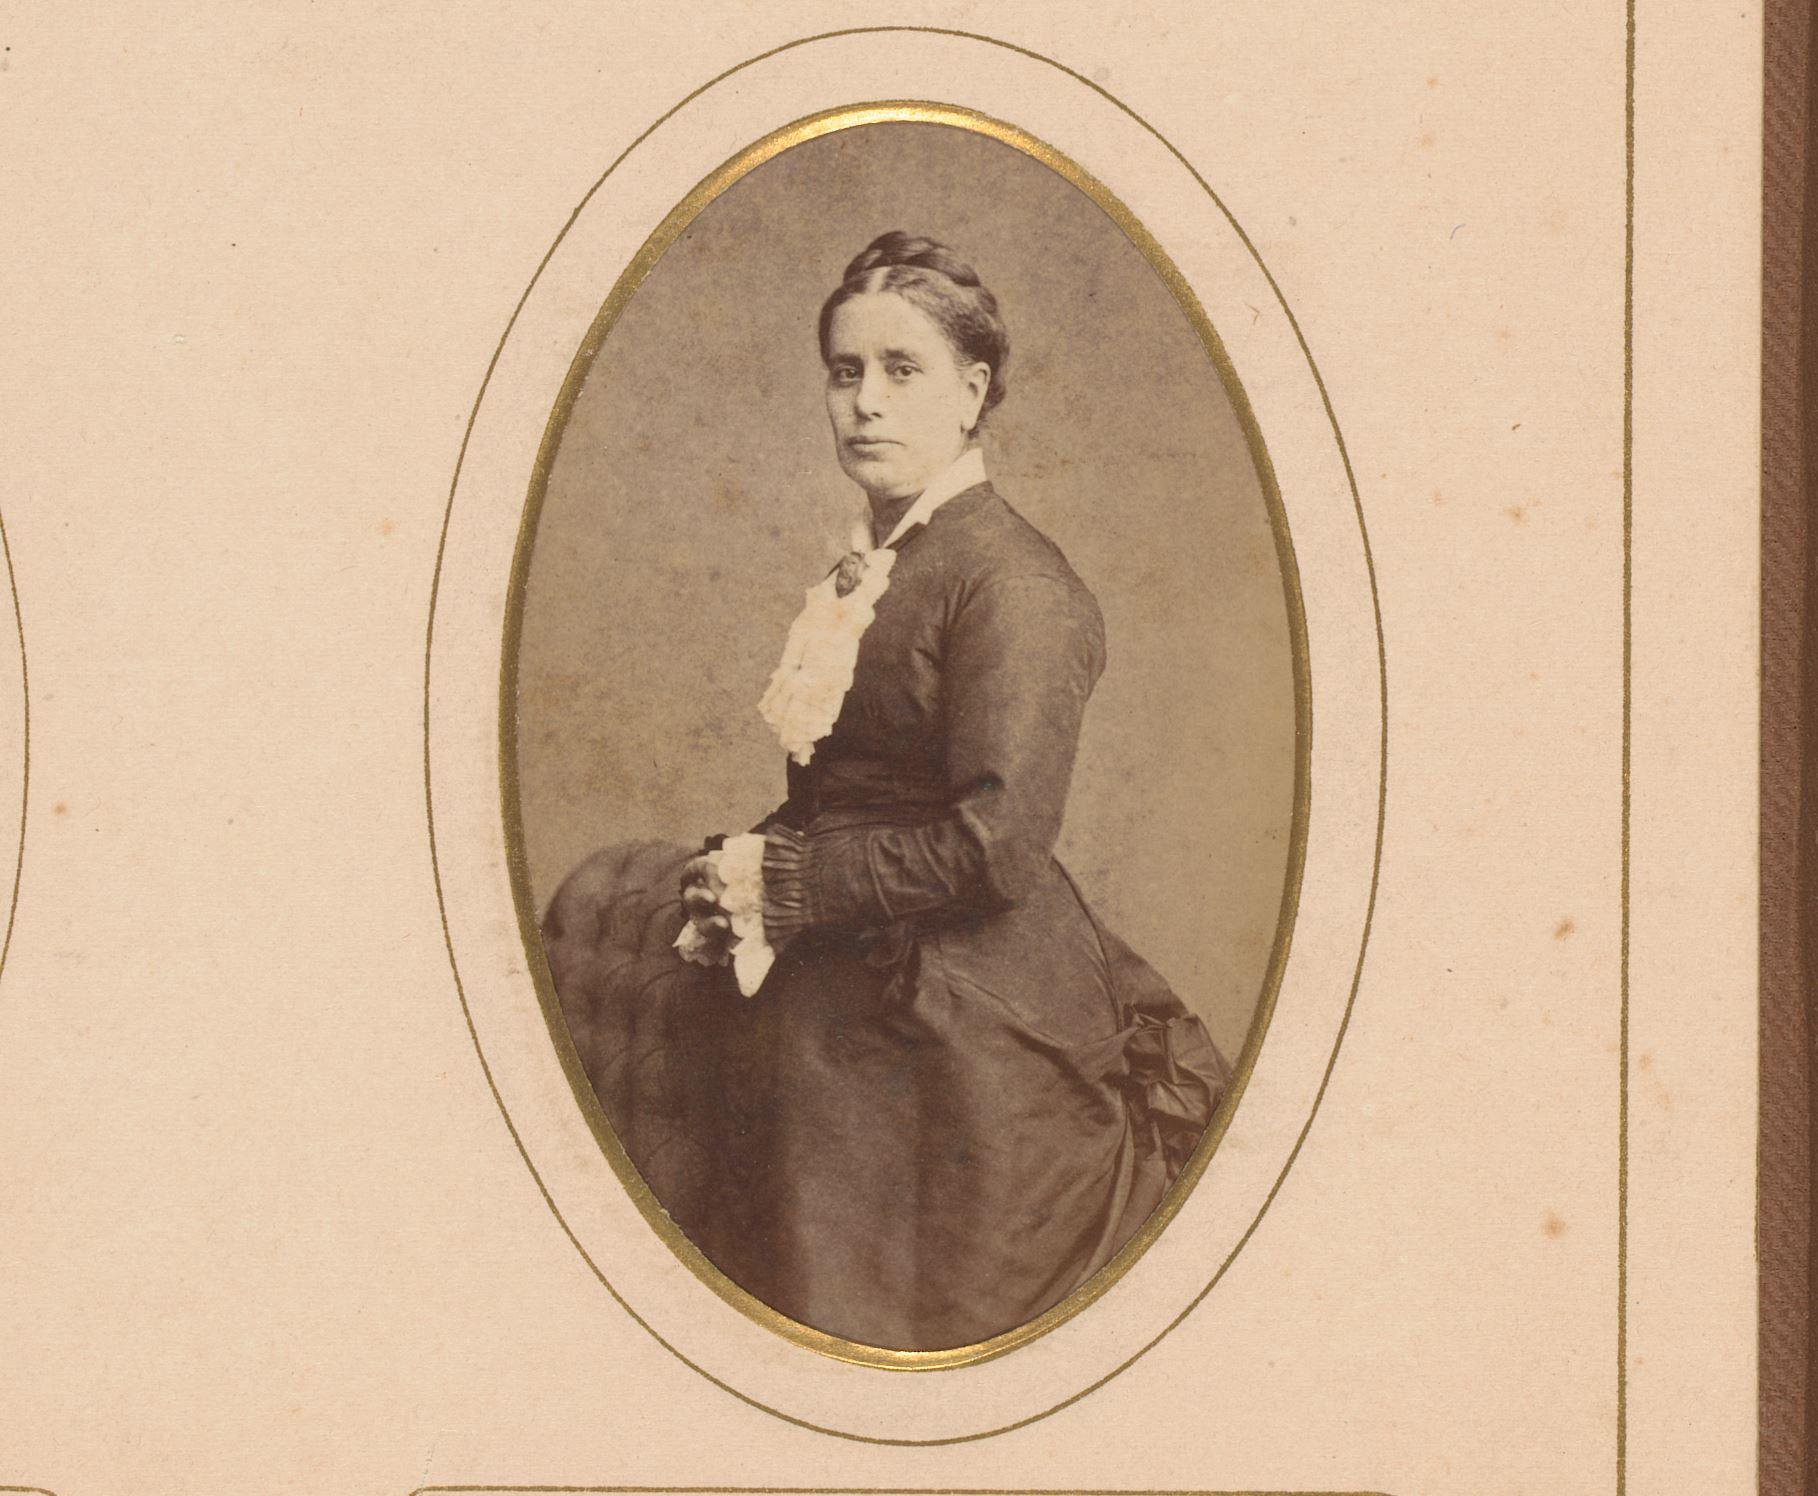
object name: carte de visite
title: Portret van een vrouw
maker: johannes wilhelmus franciscus offenberg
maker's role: fotograaf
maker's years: 1839-1919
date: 1867-1888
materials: cardboard, photographic support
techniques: albumen print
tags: historical persons - bb - woman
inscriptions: inscription: ‘OFFENBERG/ PHOTOGRAPHE/ DE S.M. LA REINE DES PAYS BAS/ DAMSTRAAT/ Amsterdam’